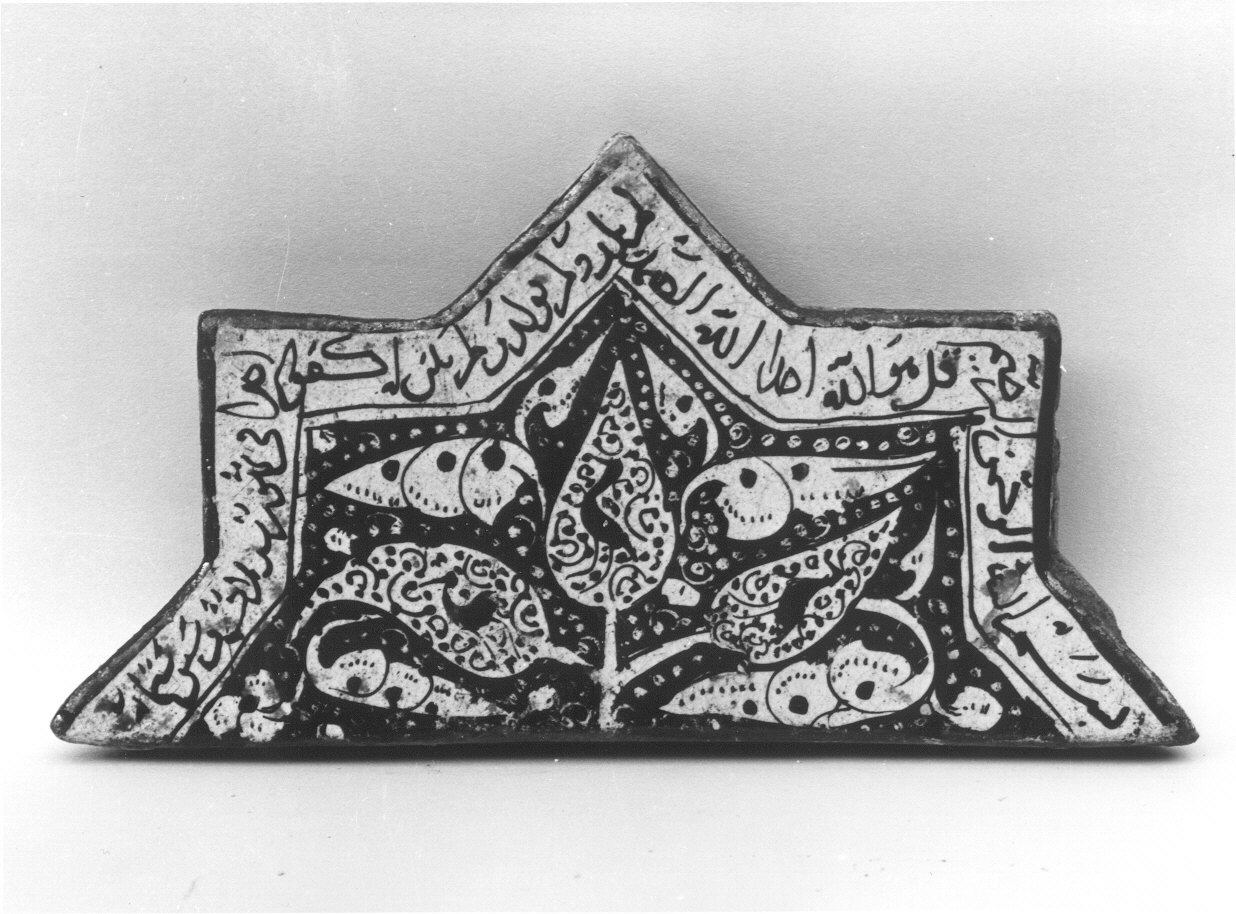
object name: tile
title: Star-Shaped Tile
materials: cobalt, glaze, stonepaste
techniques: luster painting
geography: iran